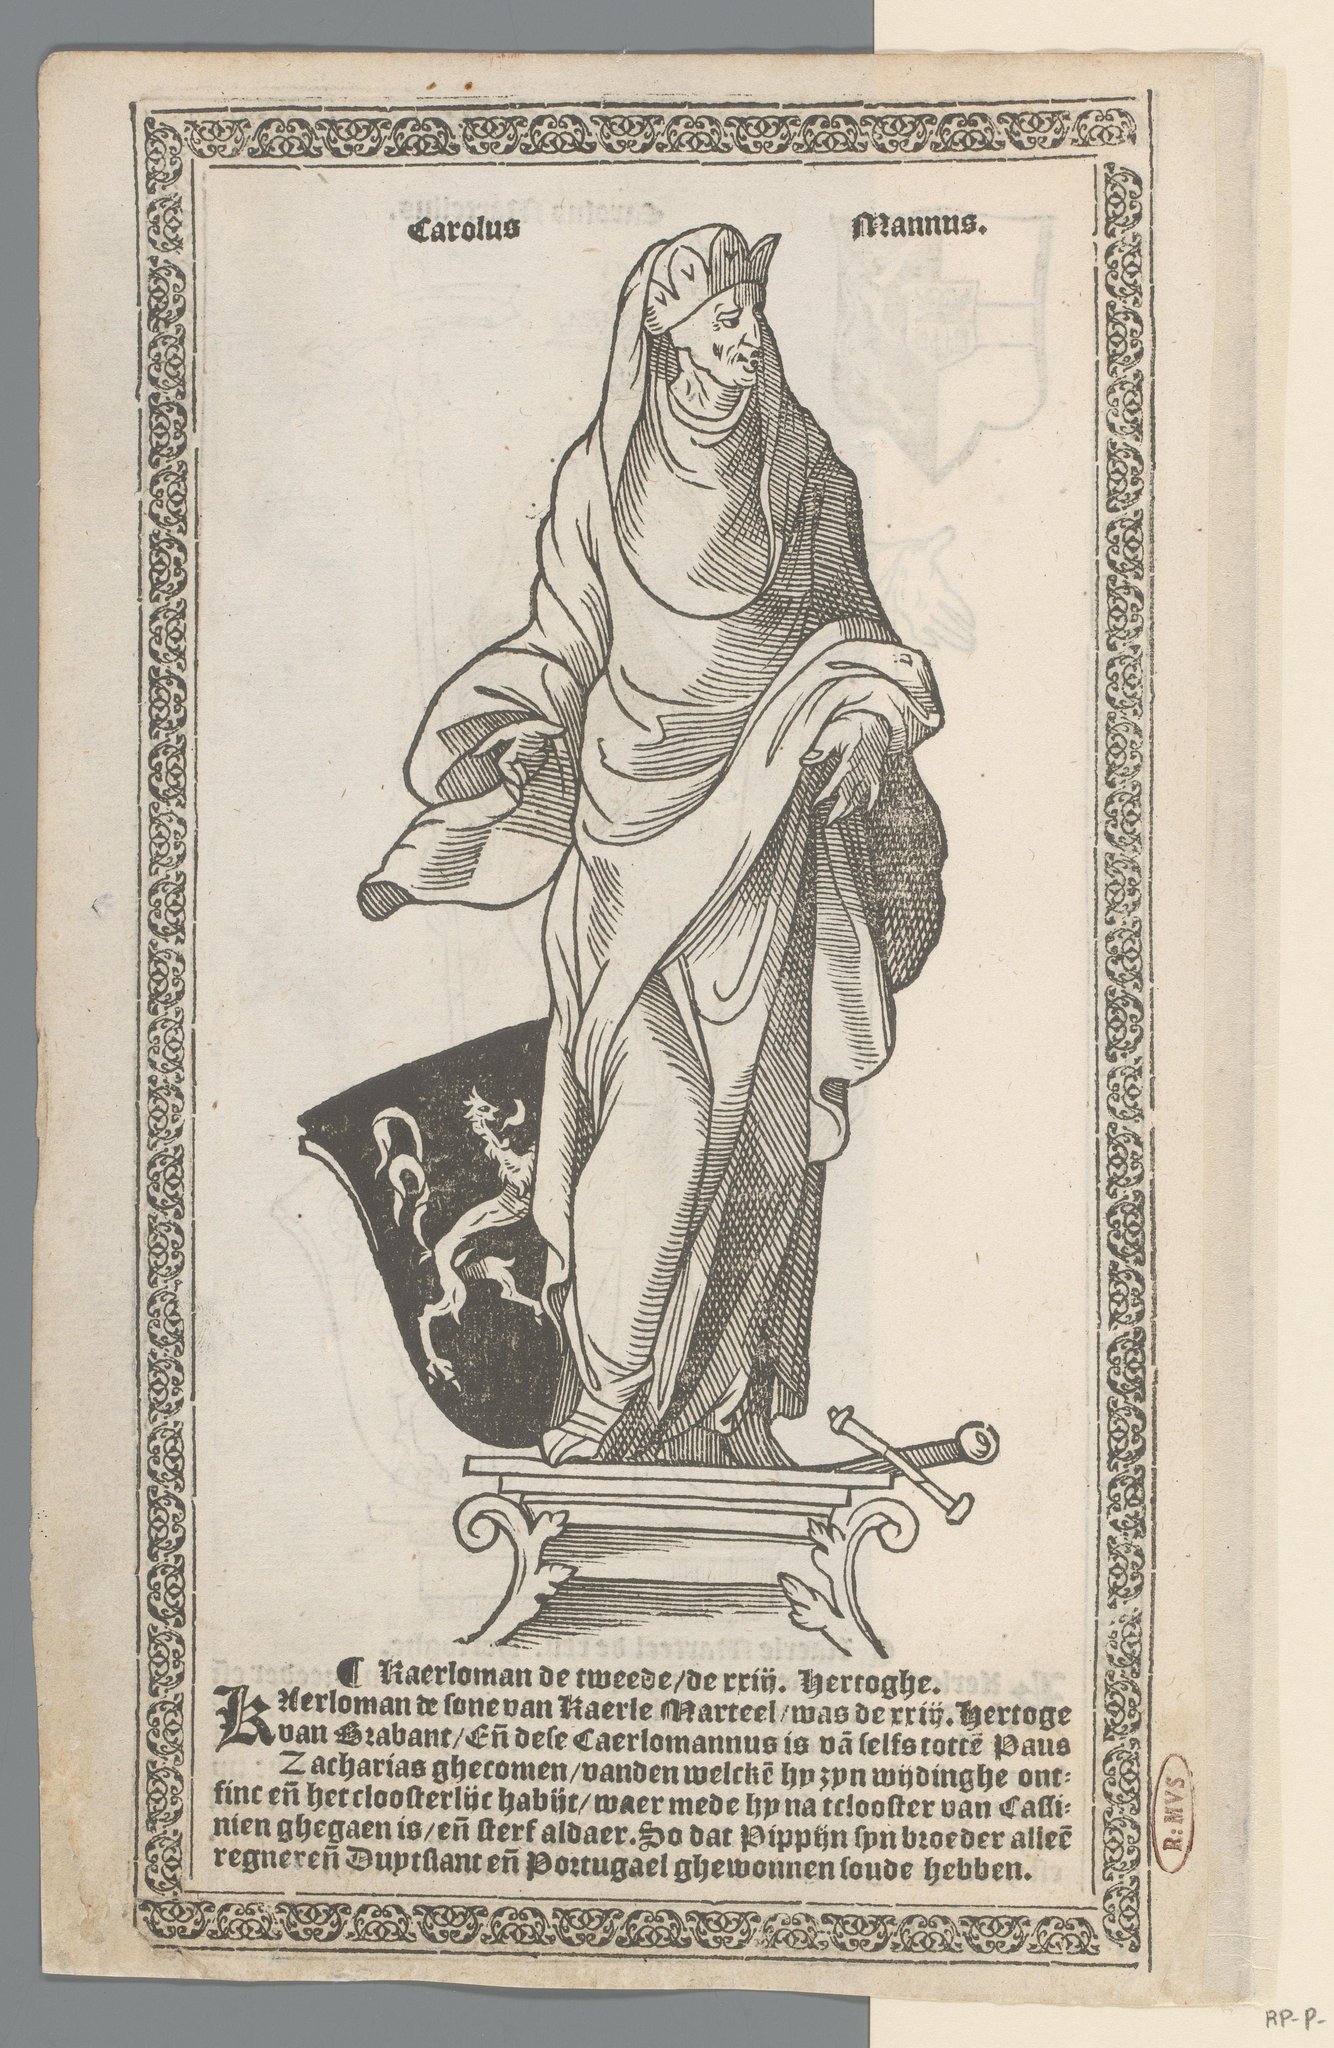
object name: book illustration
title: Portret van Karloman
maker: jan molijns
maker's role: print maker, publisher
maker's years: 1498-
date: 1565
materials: paper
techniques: letterpress printing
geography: antwerp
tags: historical persons, armorial bearing, heraldry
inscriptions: collector's mark: Lugt 2228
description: Prent uit: Dit is die afcoemste ende genalogie der hertoghen ende hertoginnen van Brabandt, (...). Antwerpen: Jan Molijns, 1565.